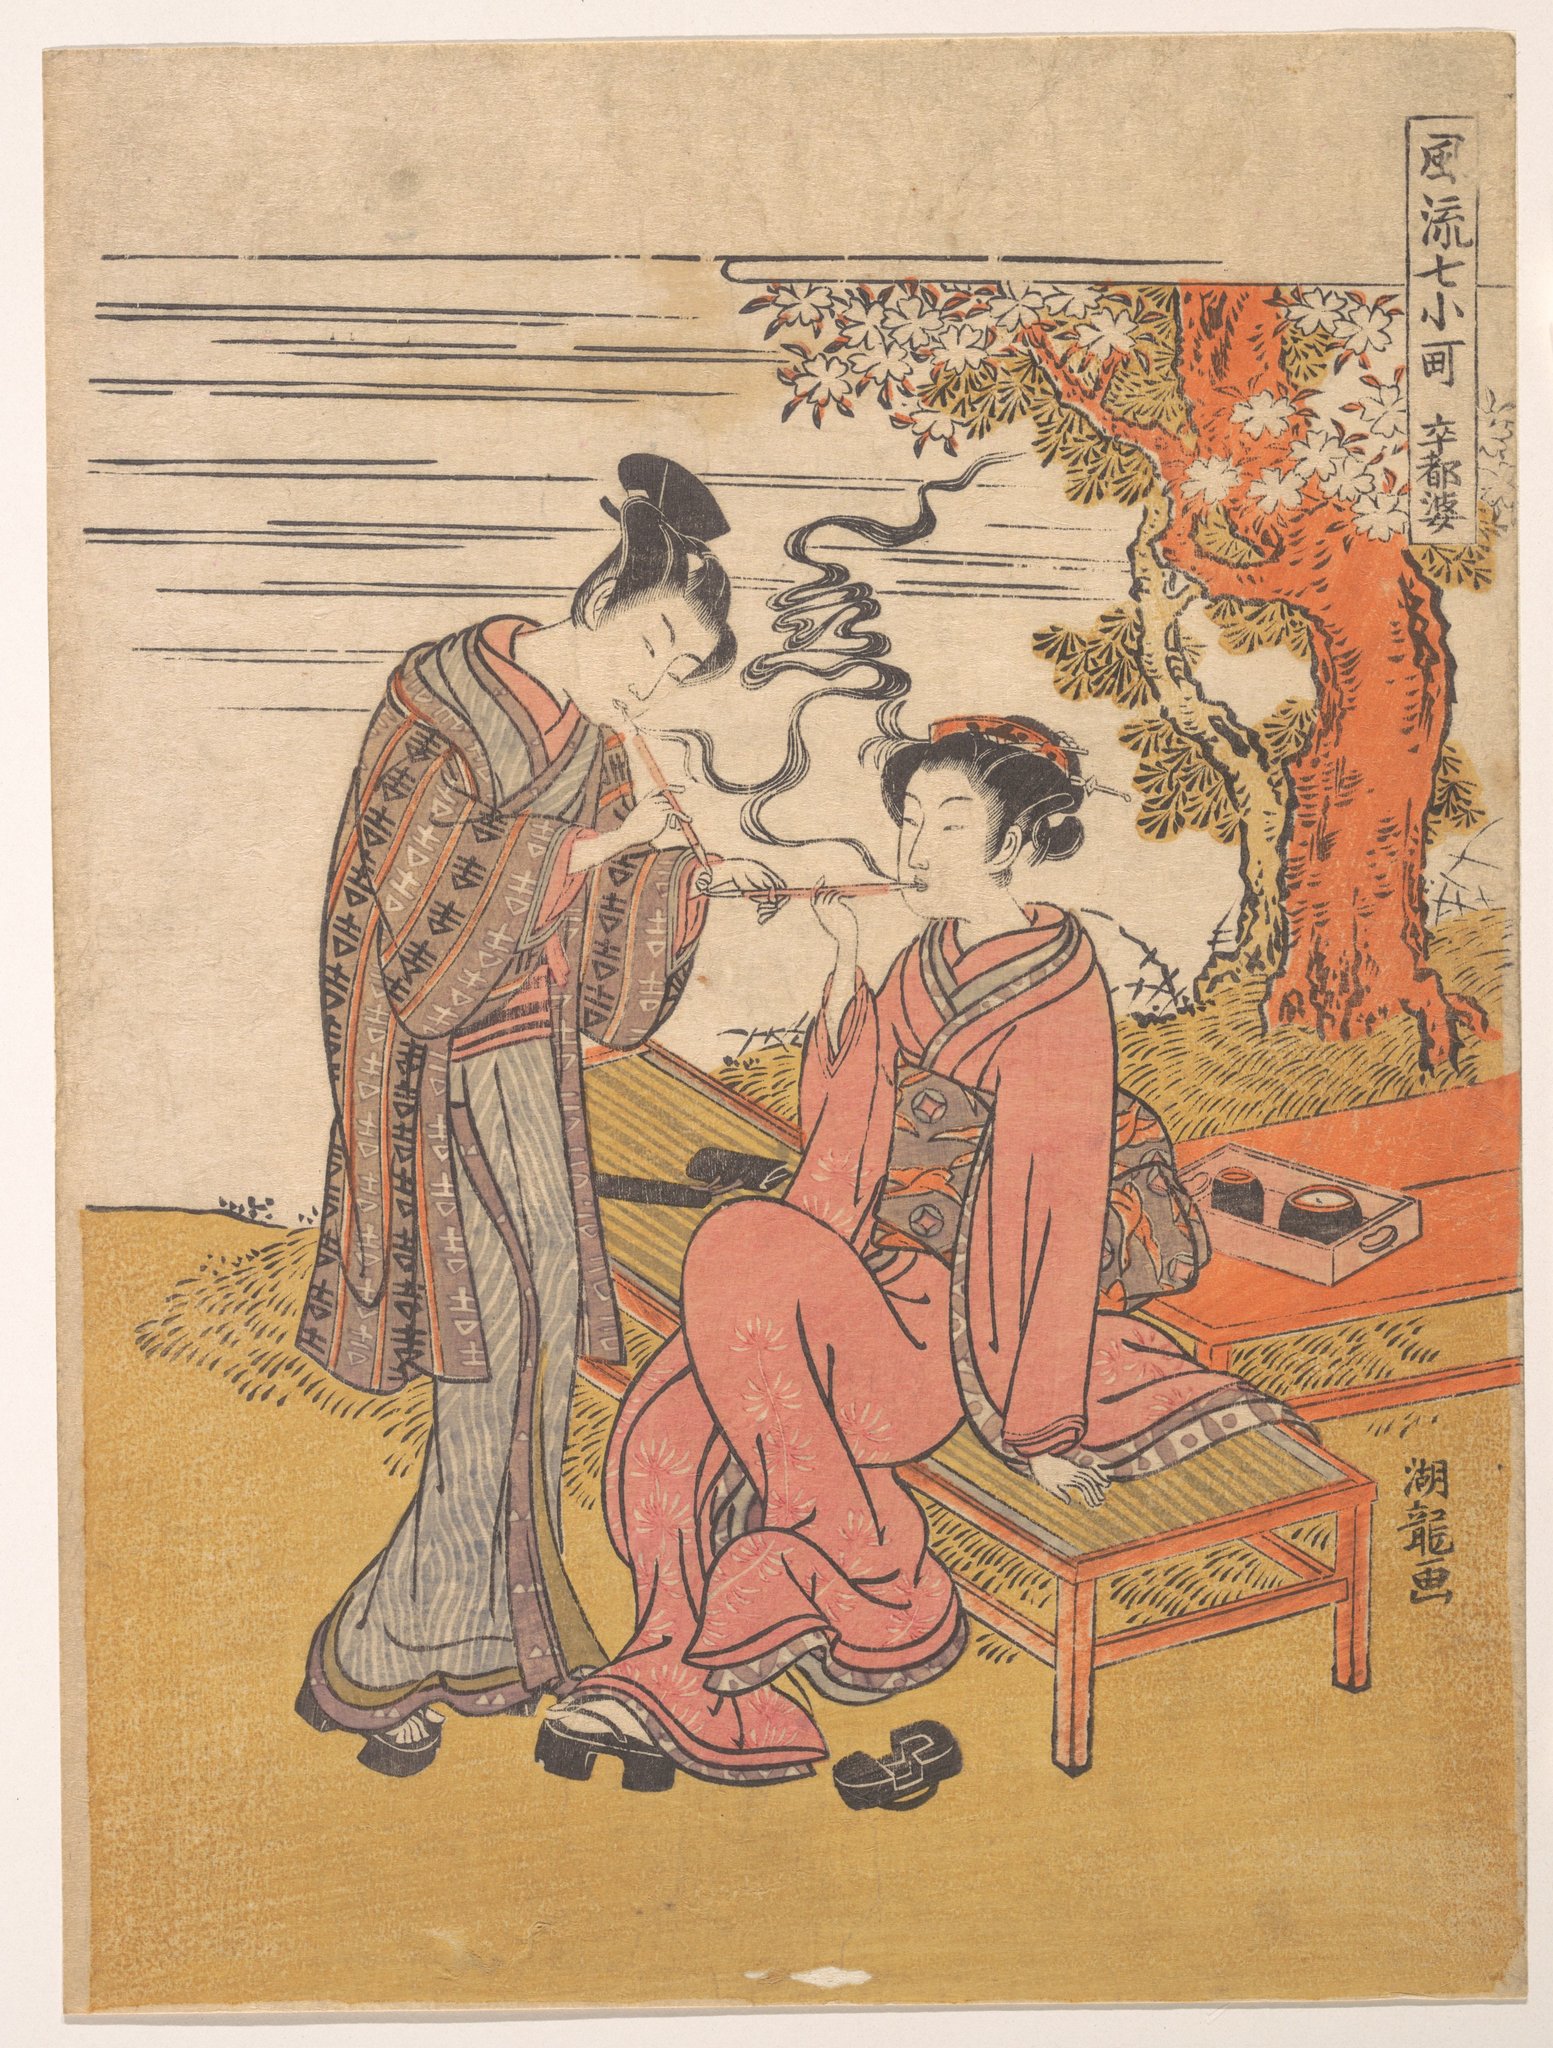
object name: print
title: Sotoba; One of Seven Komachi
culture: japanese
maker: isoda koryūsai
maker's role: artist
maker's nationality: japanese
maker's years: 1735-1790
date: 1770-1790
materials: ink, paper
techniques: woodblock print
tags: women,smoking